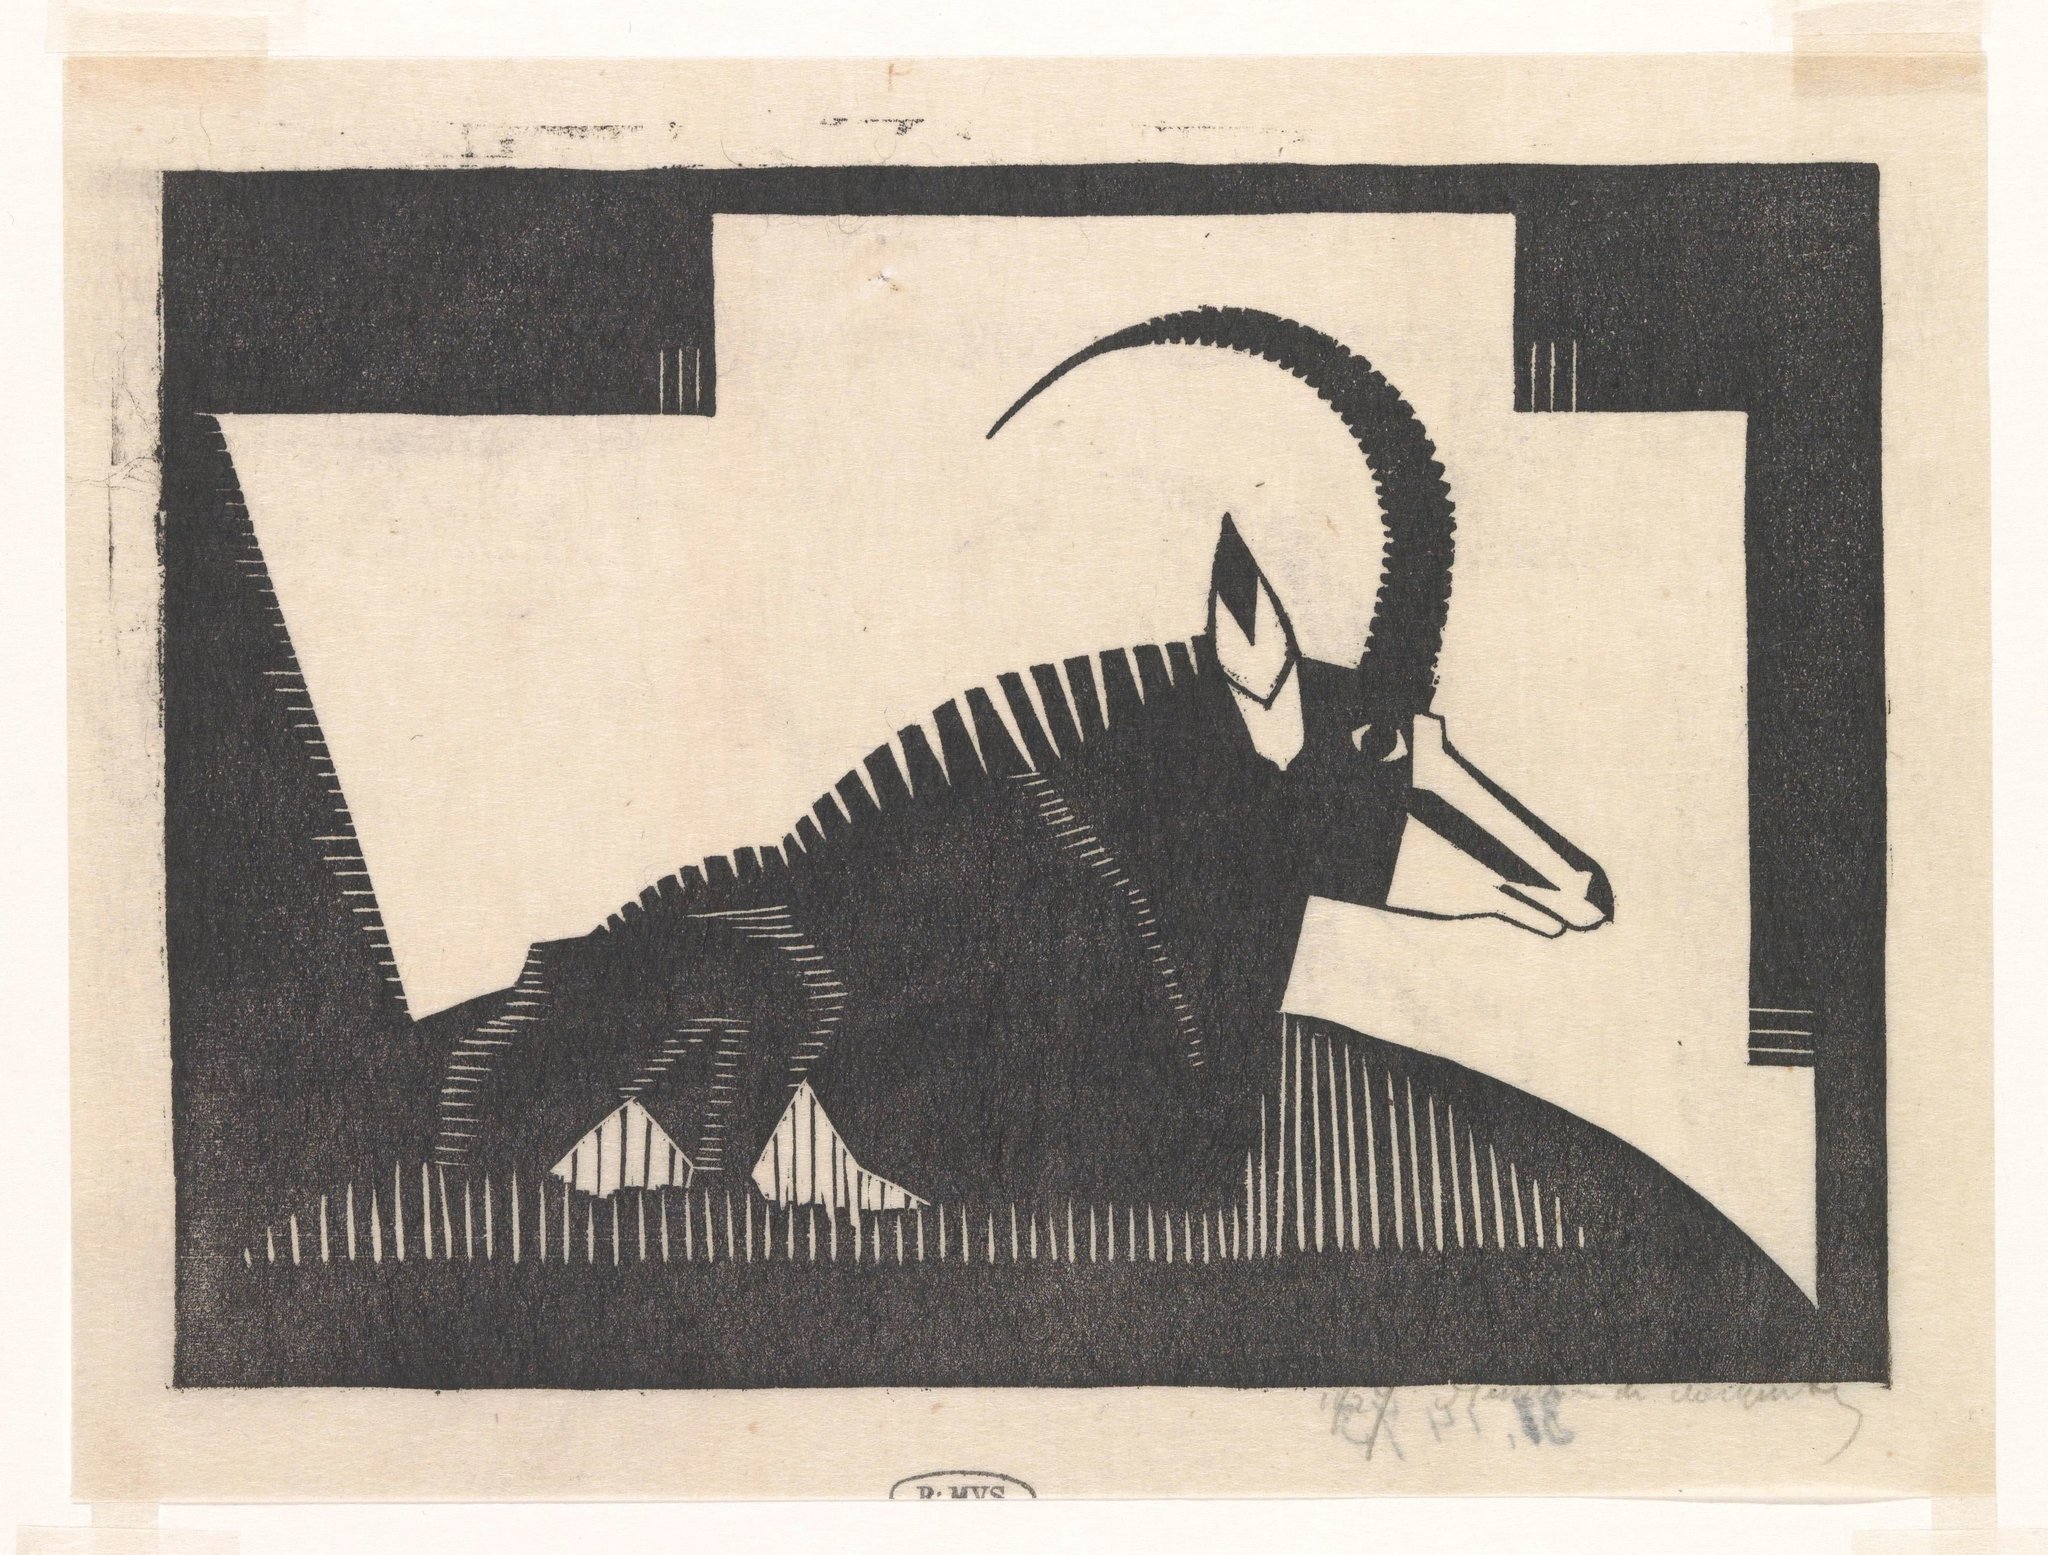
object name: print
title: Sabelantilope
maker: samuel jessurun de mesquita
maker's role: draughtsman, print maker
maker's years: 1868-1944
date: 1927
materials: paper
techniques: woodcut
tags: hoofed animals: antelope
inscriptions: collector's mark: Lugt 2228